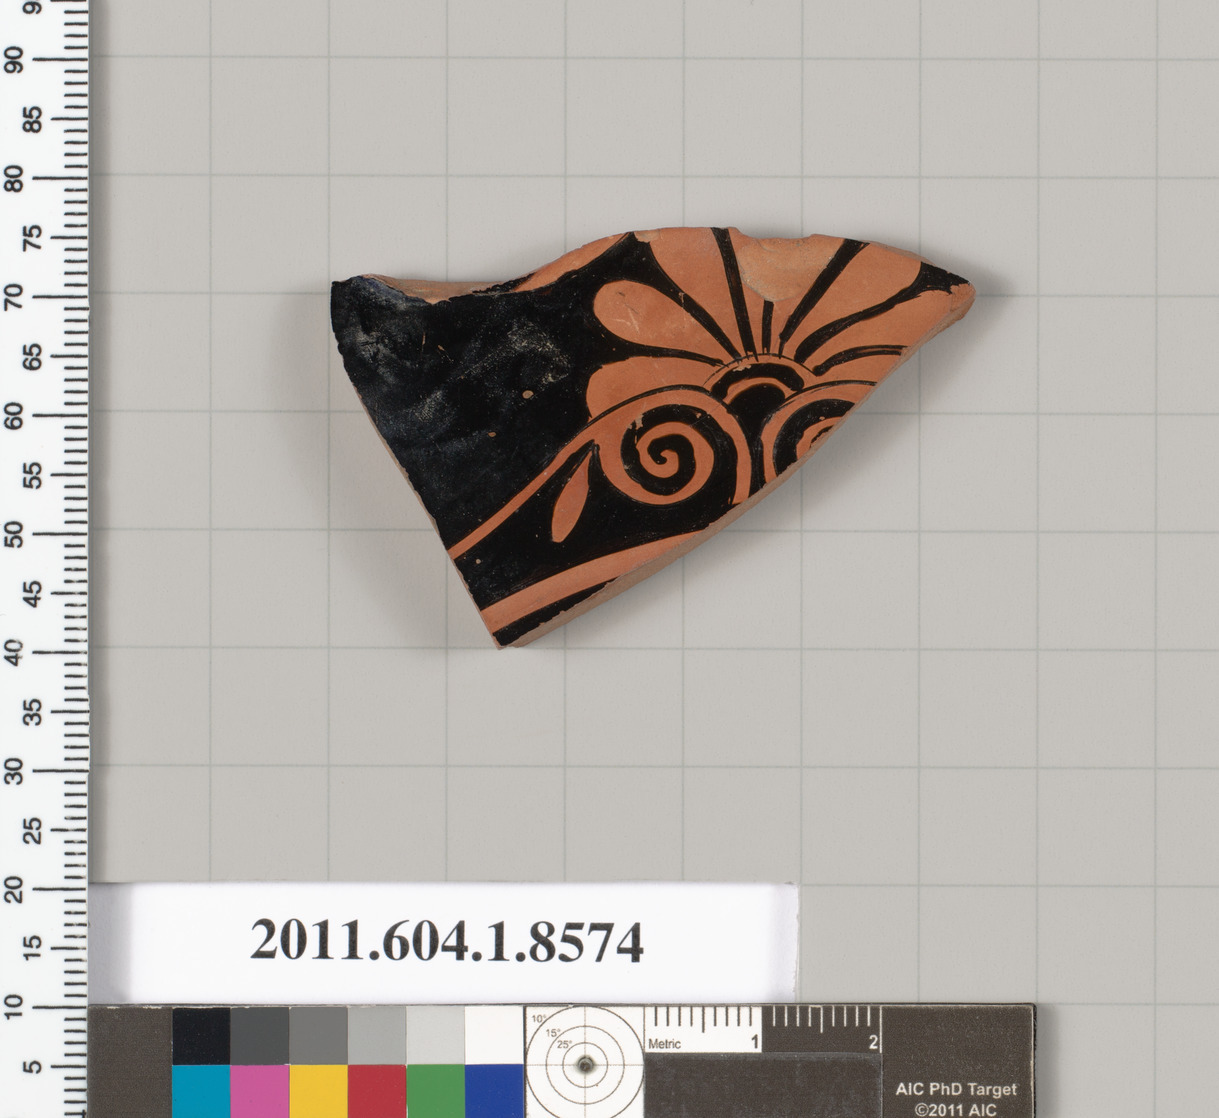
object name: kylix fragment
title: Terracotta fragment of a kylix (drinking cup)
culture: greek, attic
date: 475-451 BCE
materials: terracotta